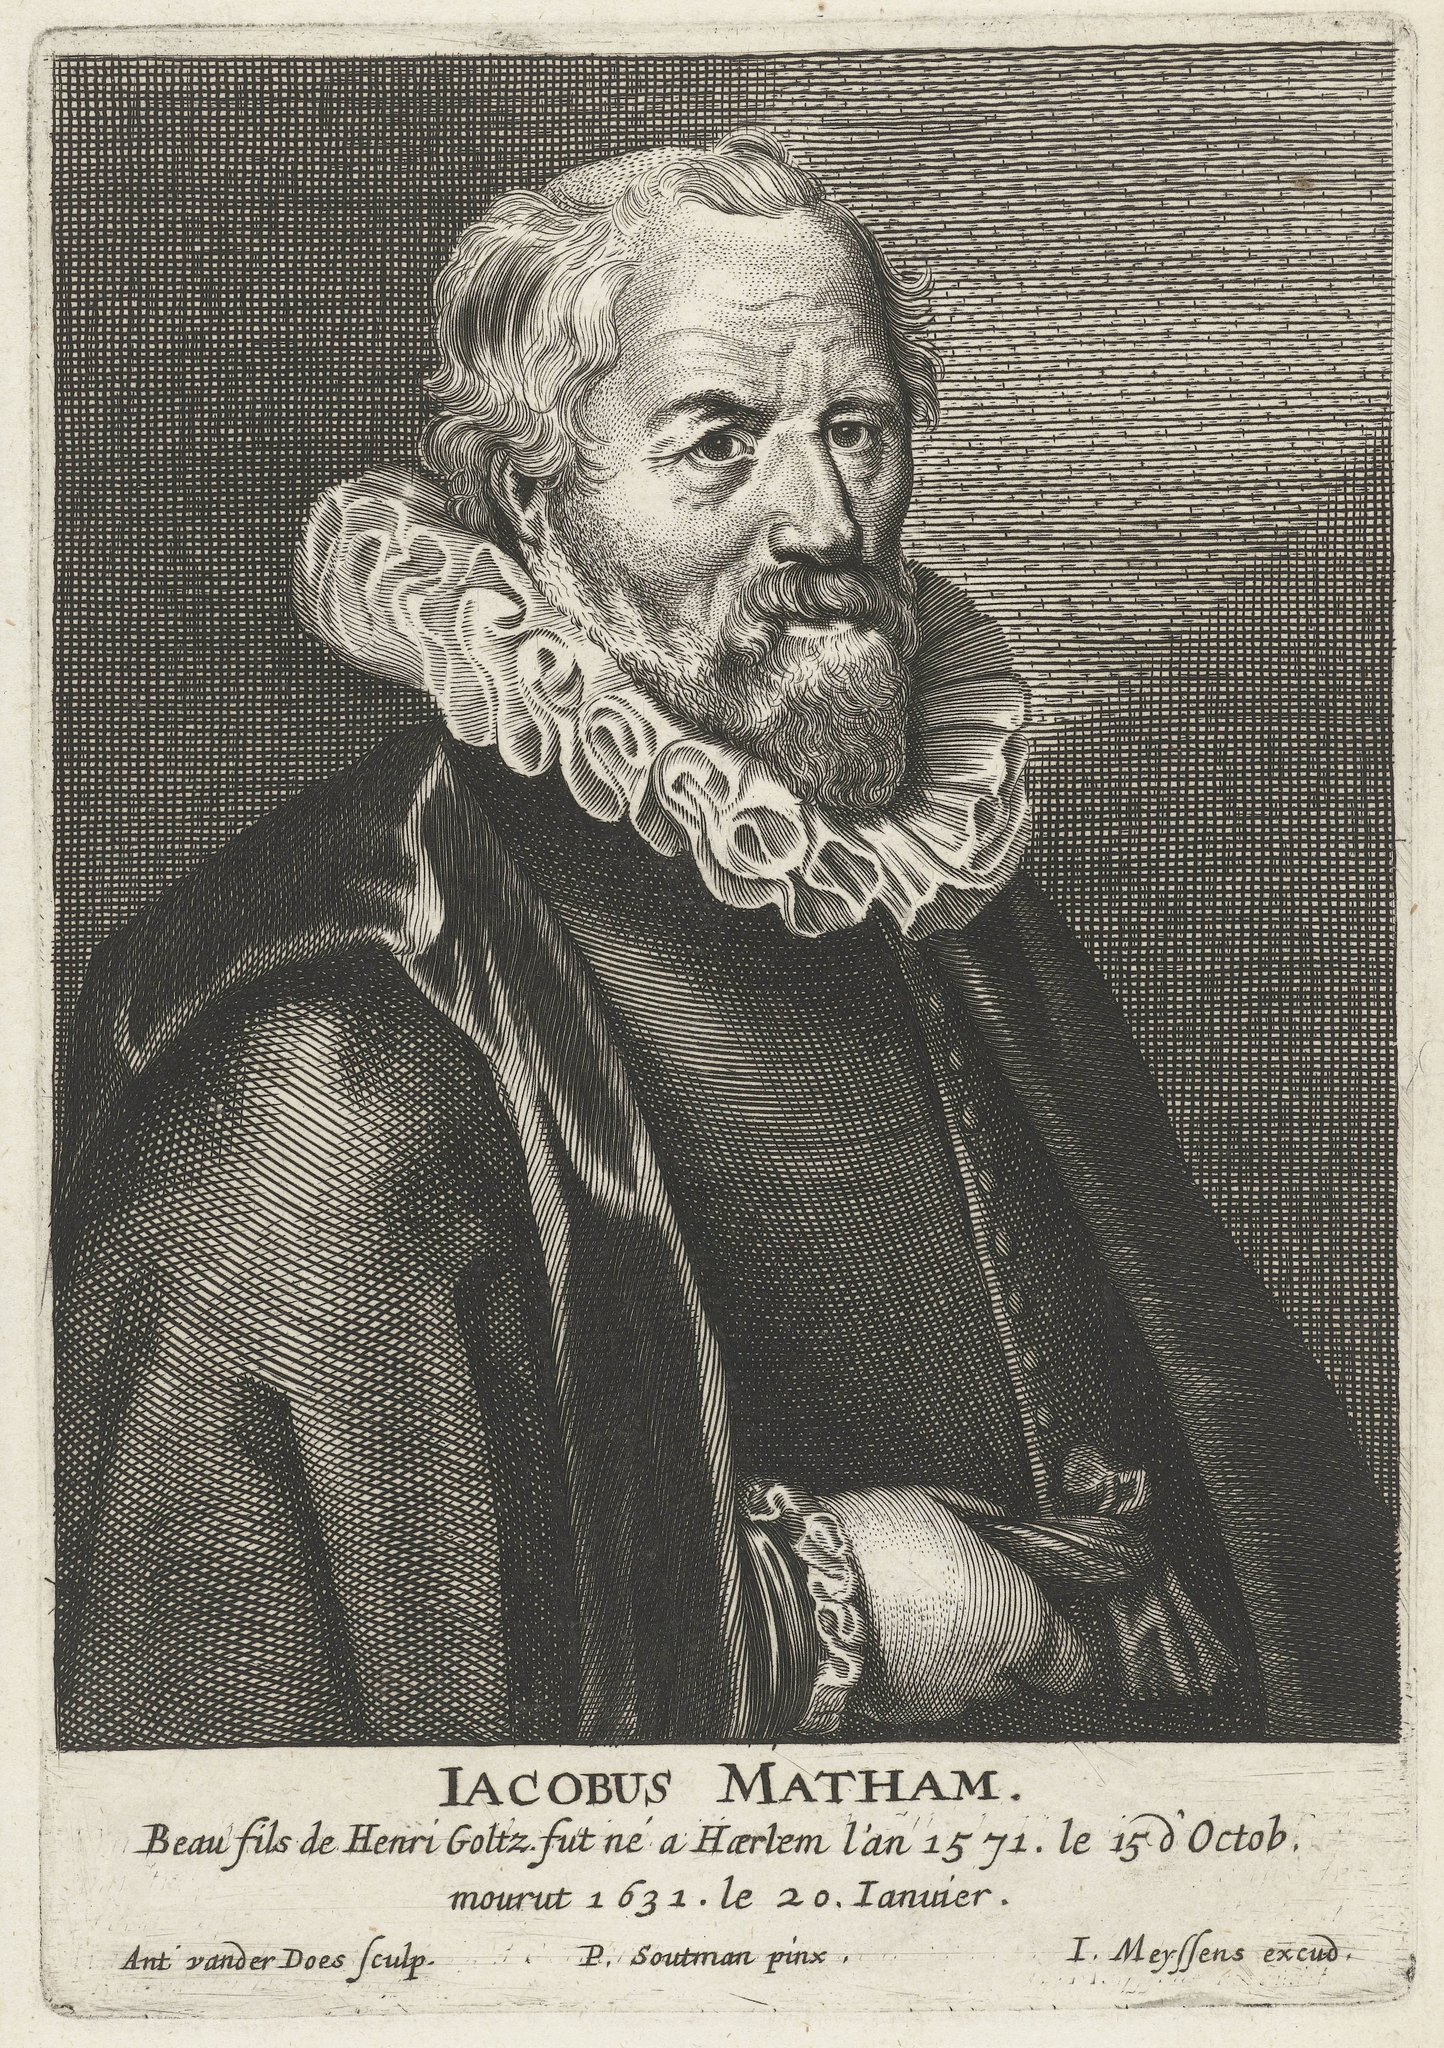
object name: print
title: Portret van Jacob Matham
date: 1631-1680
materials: paper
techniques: engraving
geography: southern netherlands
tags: print maker, draughtsman, jacob matham, neck-gear: collar (+ men's clothes), tapestry weaver, gobelin maker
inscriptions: collector's mark: Lugt 2228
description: Portret van Jacob Matham, staand ten halven lijve met plooikraag en mantel. In ondermarge vier regels Franse tekst.